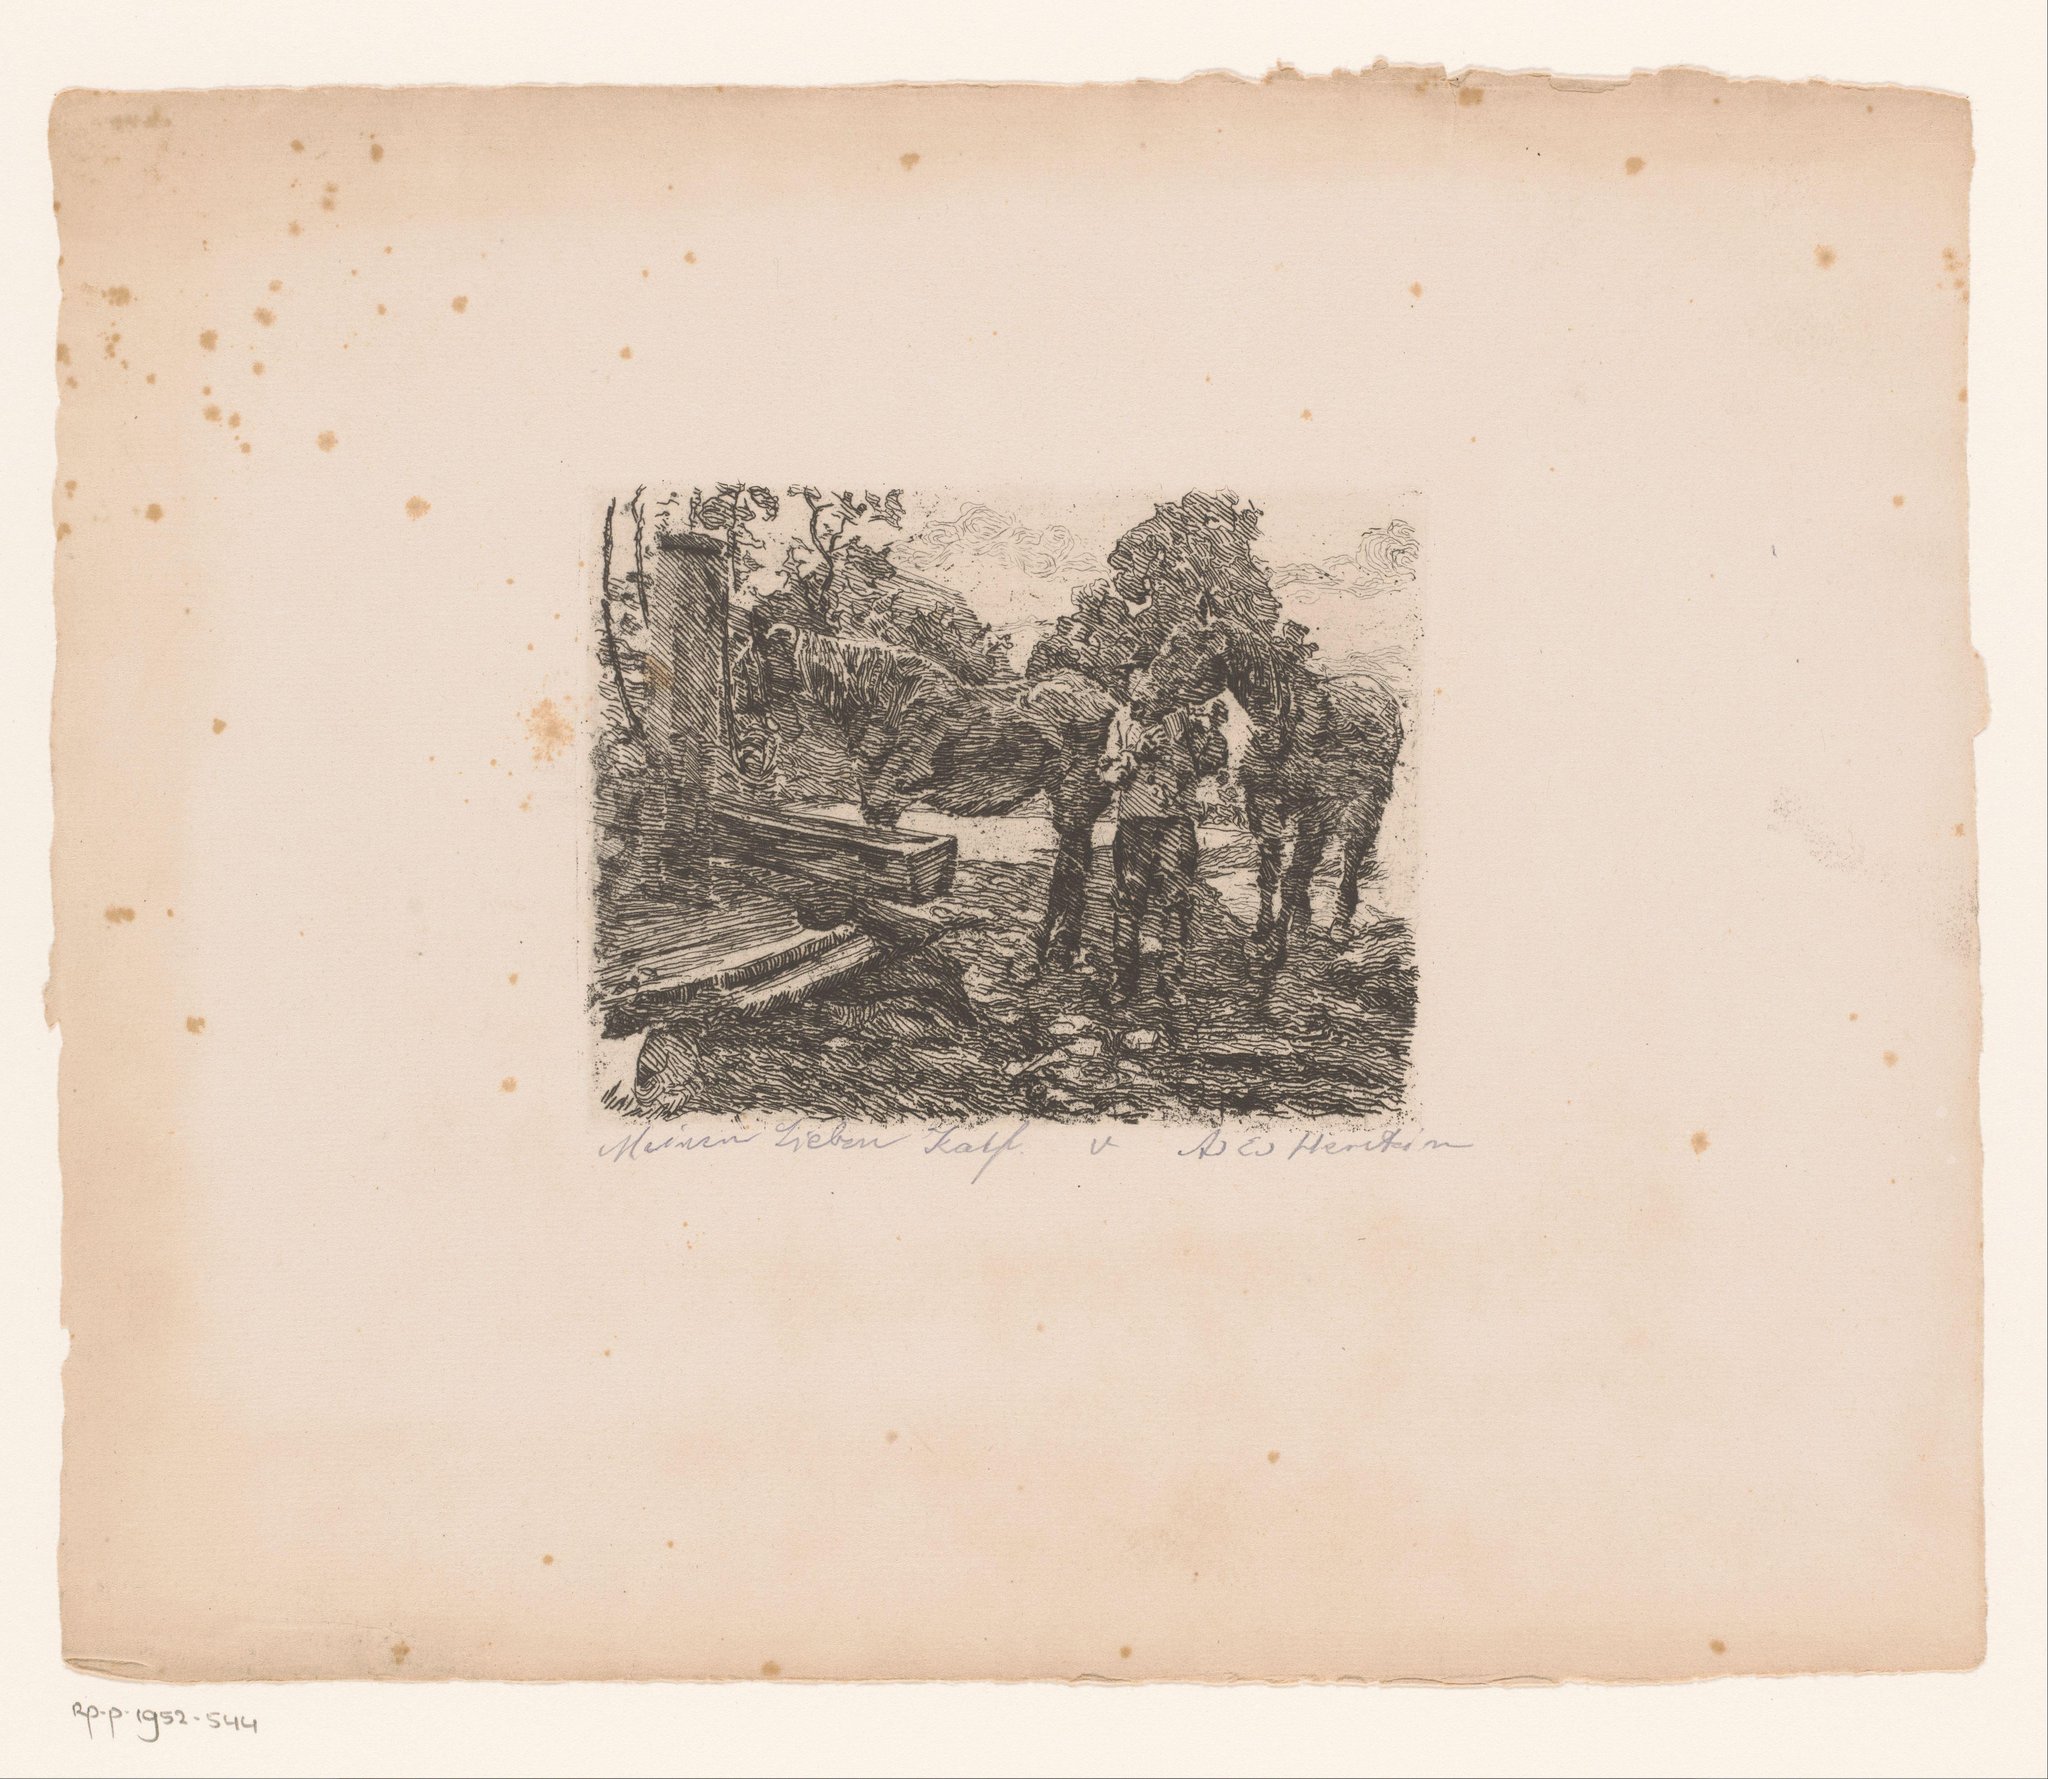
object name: print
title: Twee paarden bij drinkbak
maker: adolf eduard herstein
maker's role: print maker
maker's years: 1869-1932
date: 1879-1932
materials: paper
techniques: drypoint, etching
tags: horse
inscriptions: collector's mark: Lugt 2228, dedication: ‘Meinen lieben Kalf’